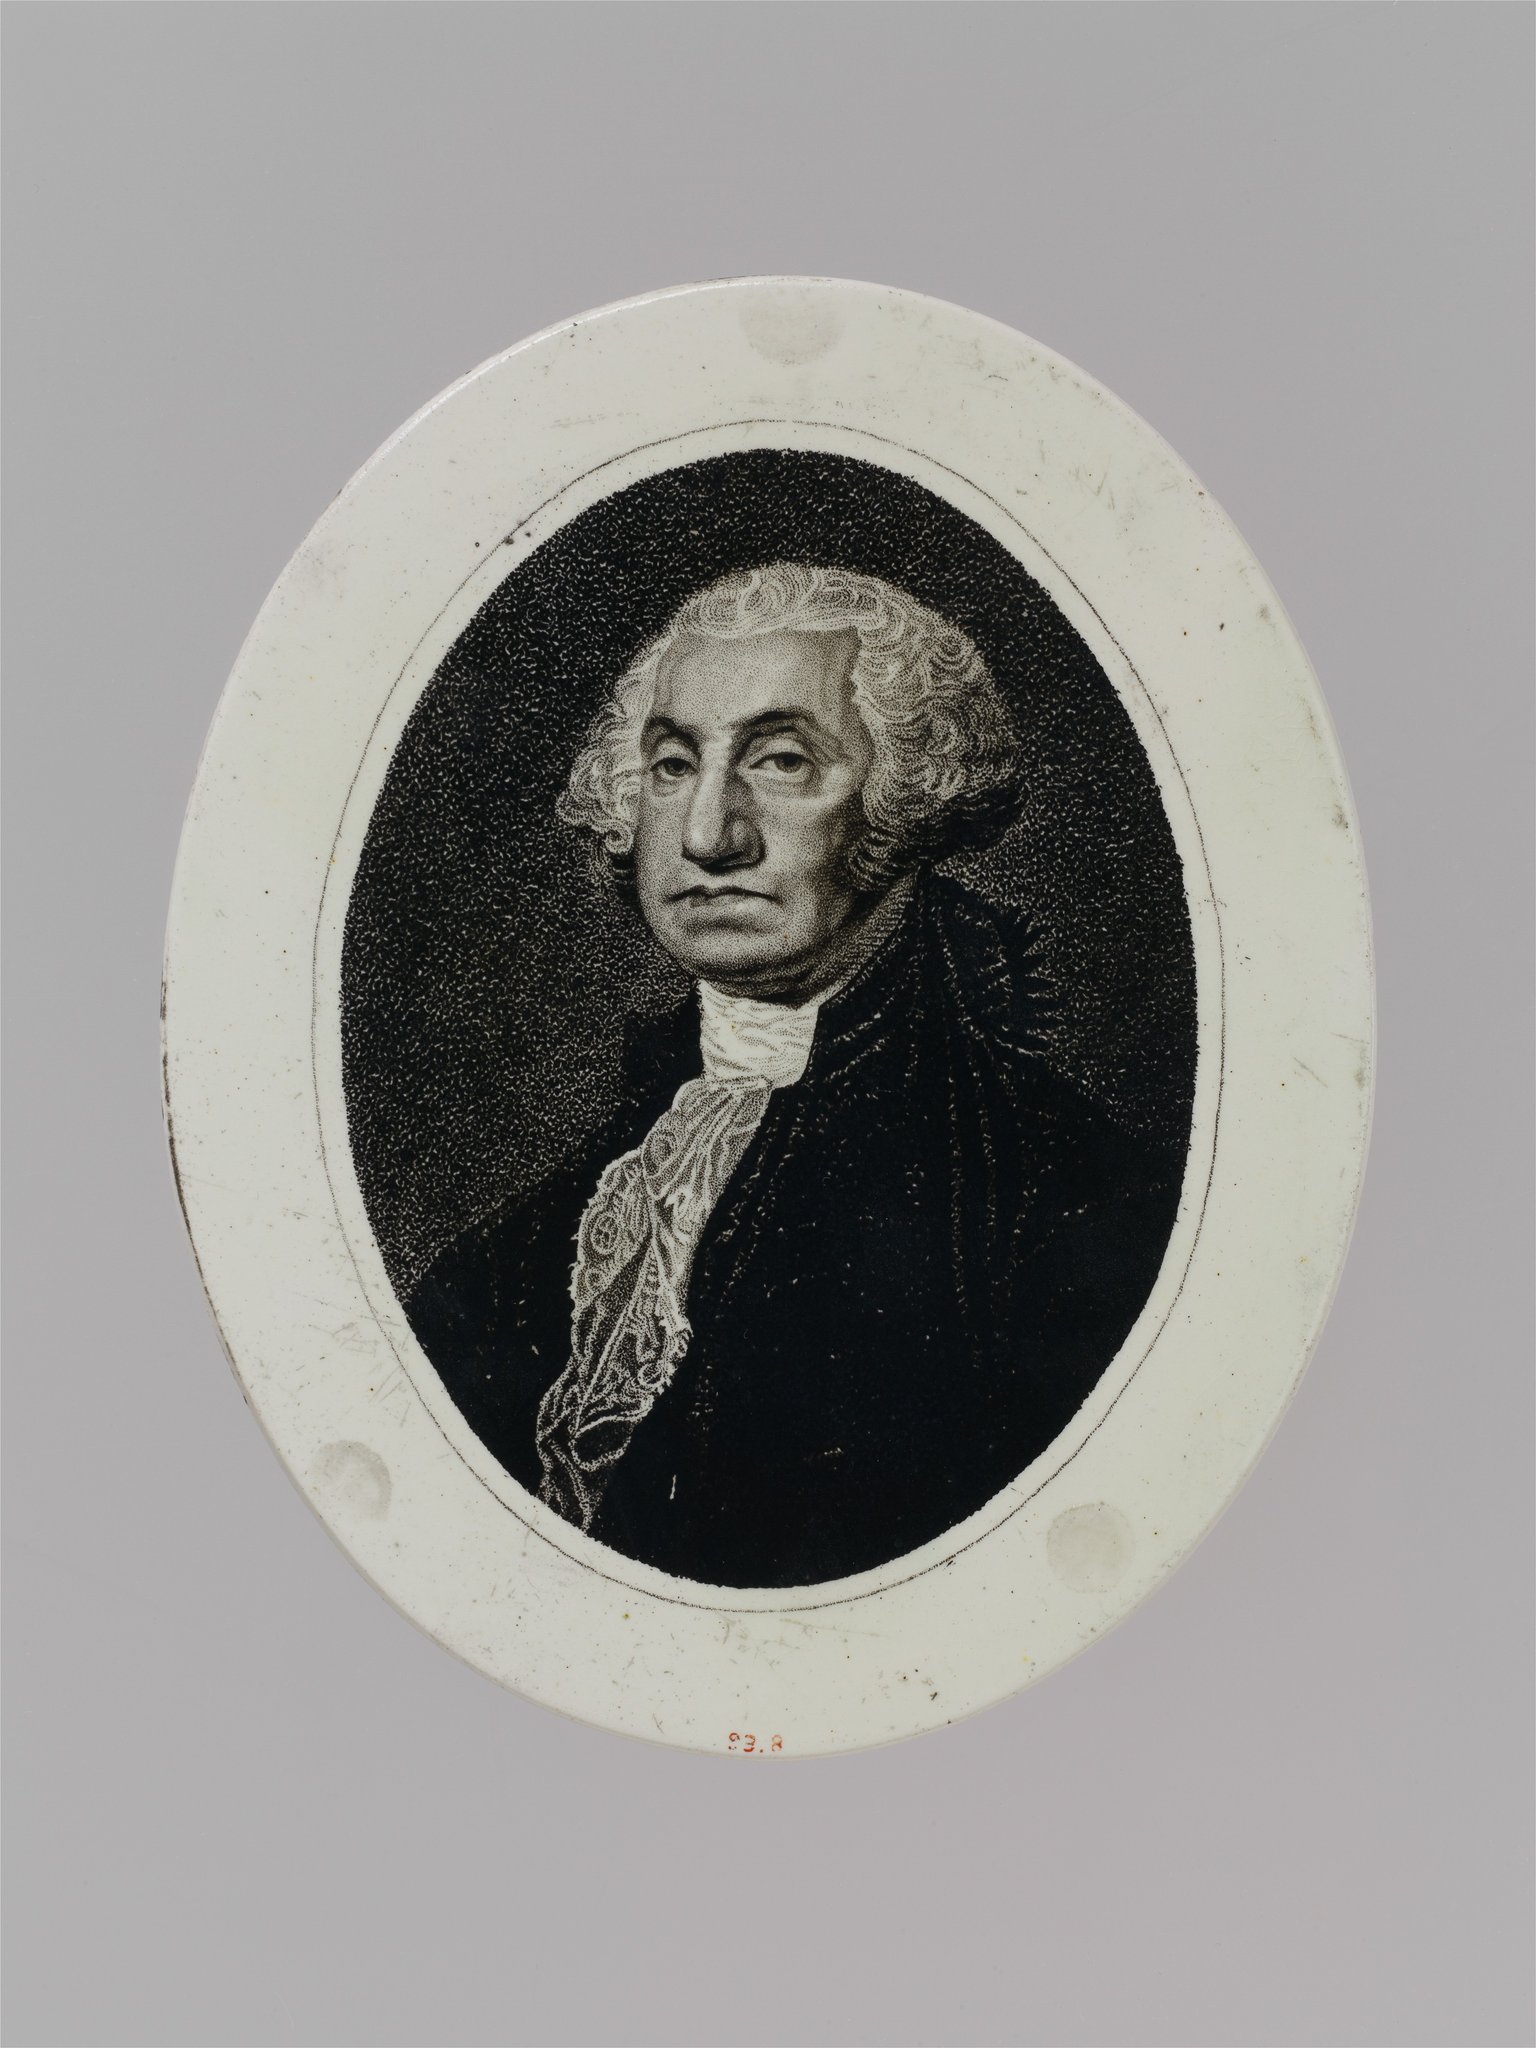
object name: medallion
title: Medallion of George Washington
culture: british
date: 1776-1796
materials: earthenware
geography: england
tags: george washington,men,portraits